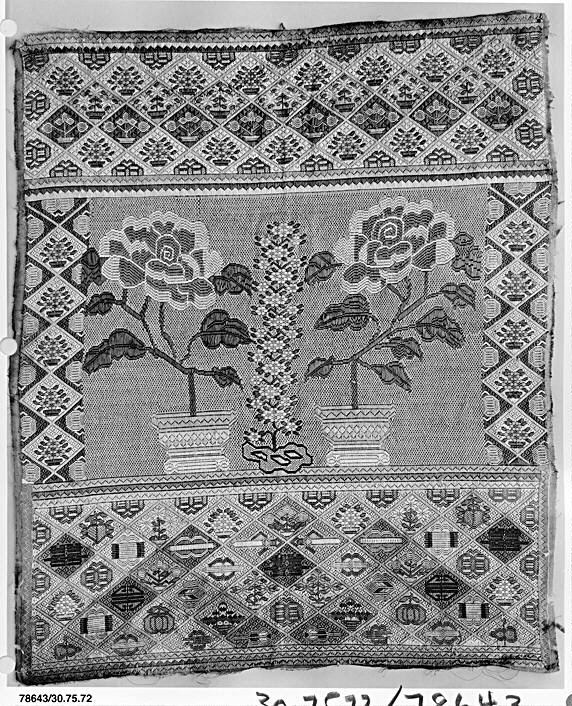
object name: panel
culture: chinese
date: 1736-1795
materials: silk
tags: flowers